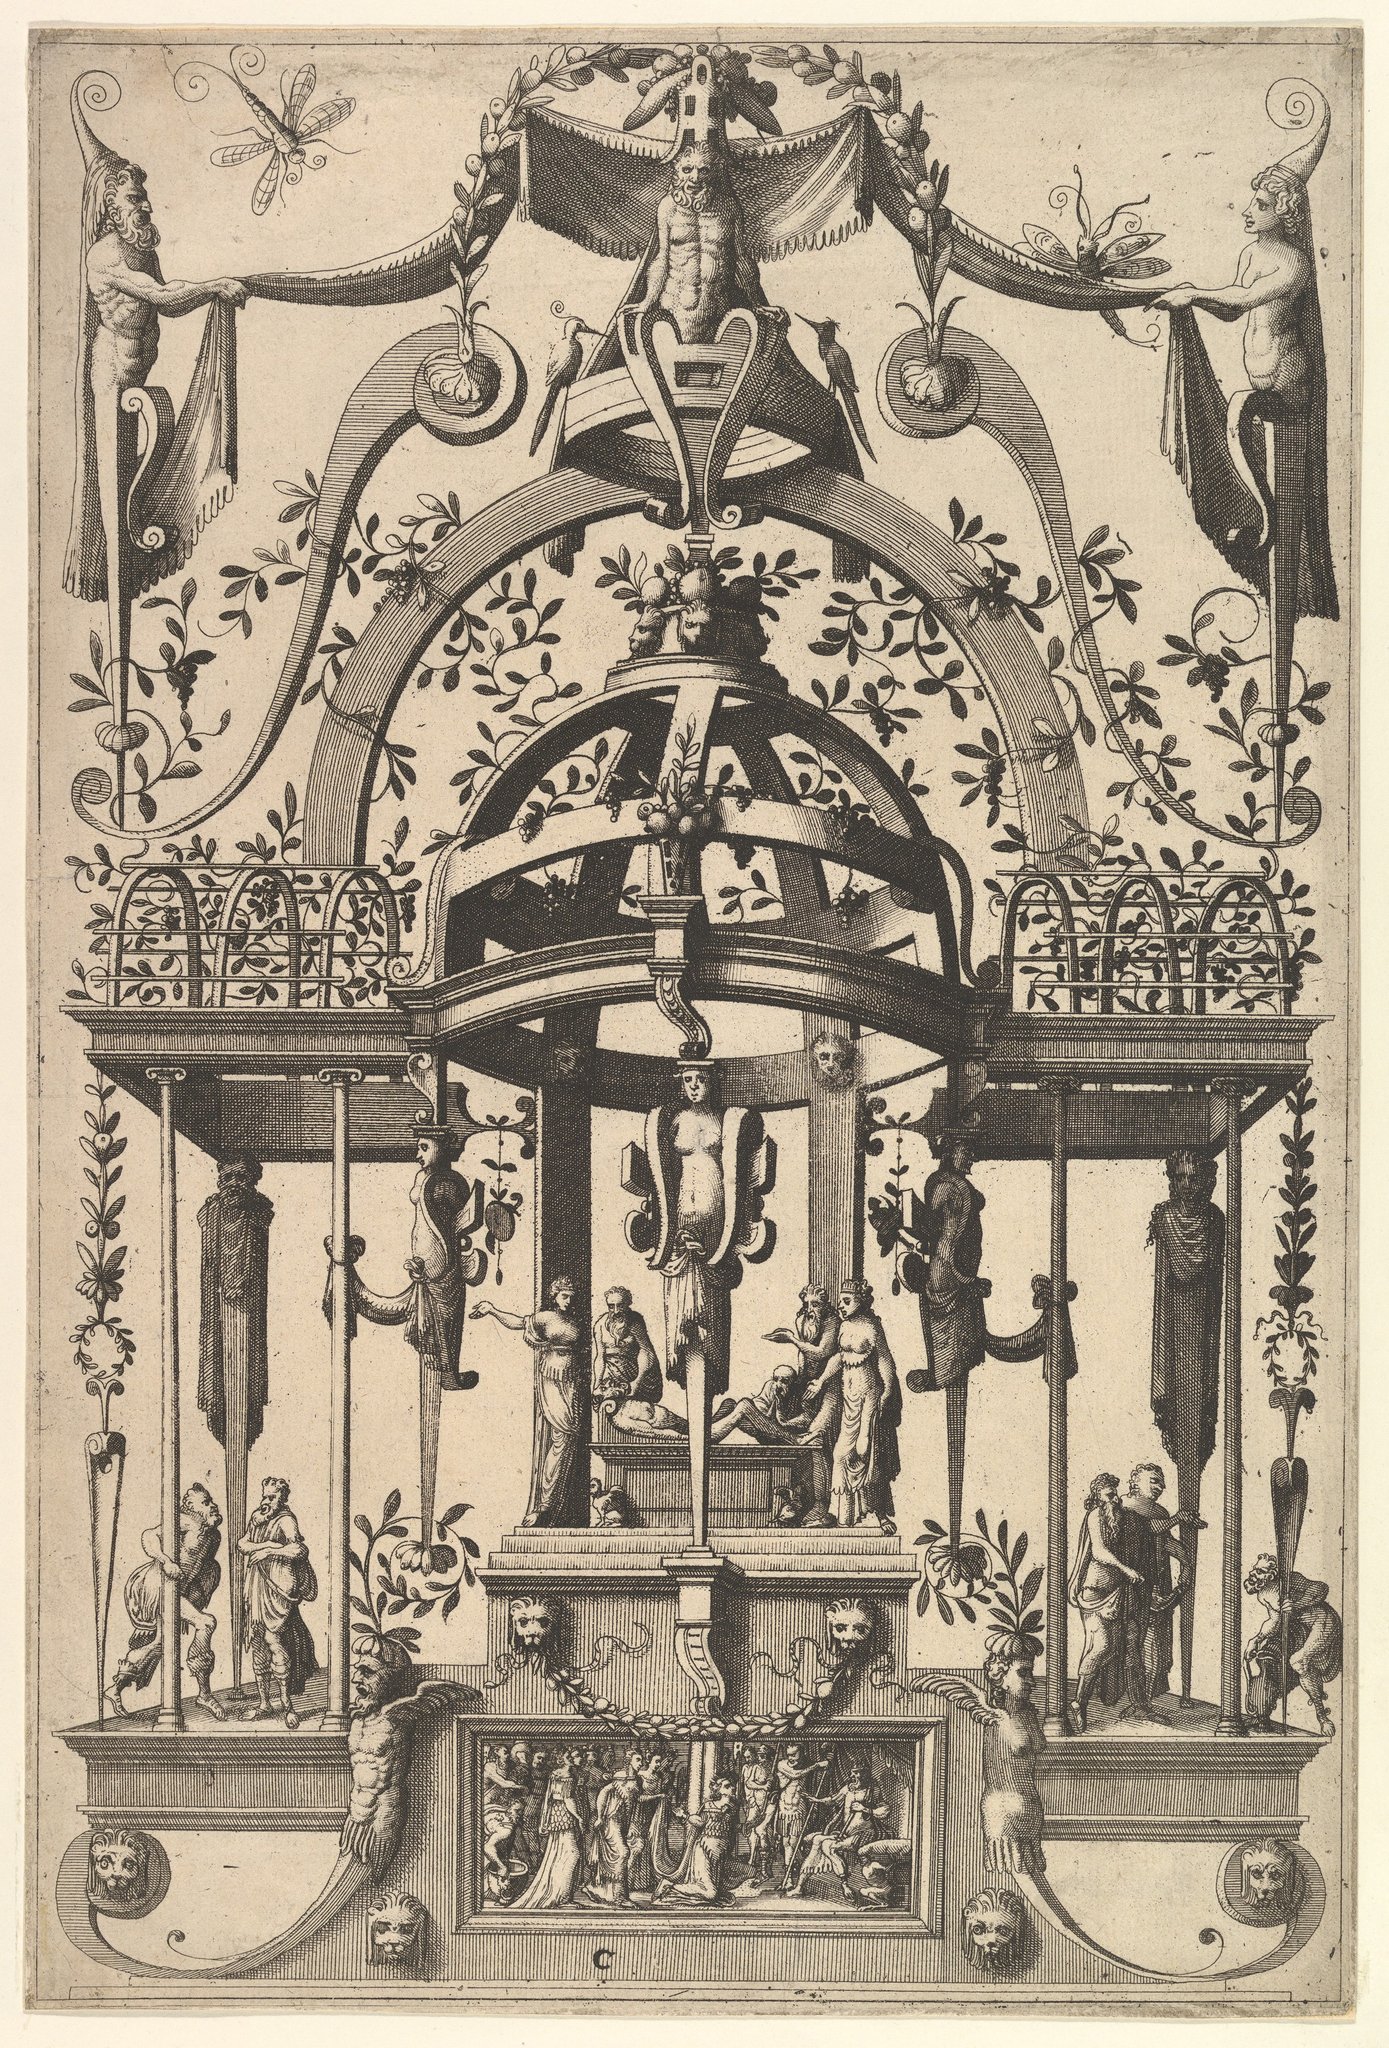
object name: book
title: Surface Decoration, Grotesque with Strapwork, Burial Scene in the Tempietto, in the Bas Relief Esther before Ahasuerus from Veelderleij Veranderinghe van grotissen ende Compertimenten...Libro Primo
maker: cornelis floris ii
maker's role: artist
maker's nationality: netherlandish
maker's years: 1514-1575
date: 1556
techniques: etching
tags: tombs